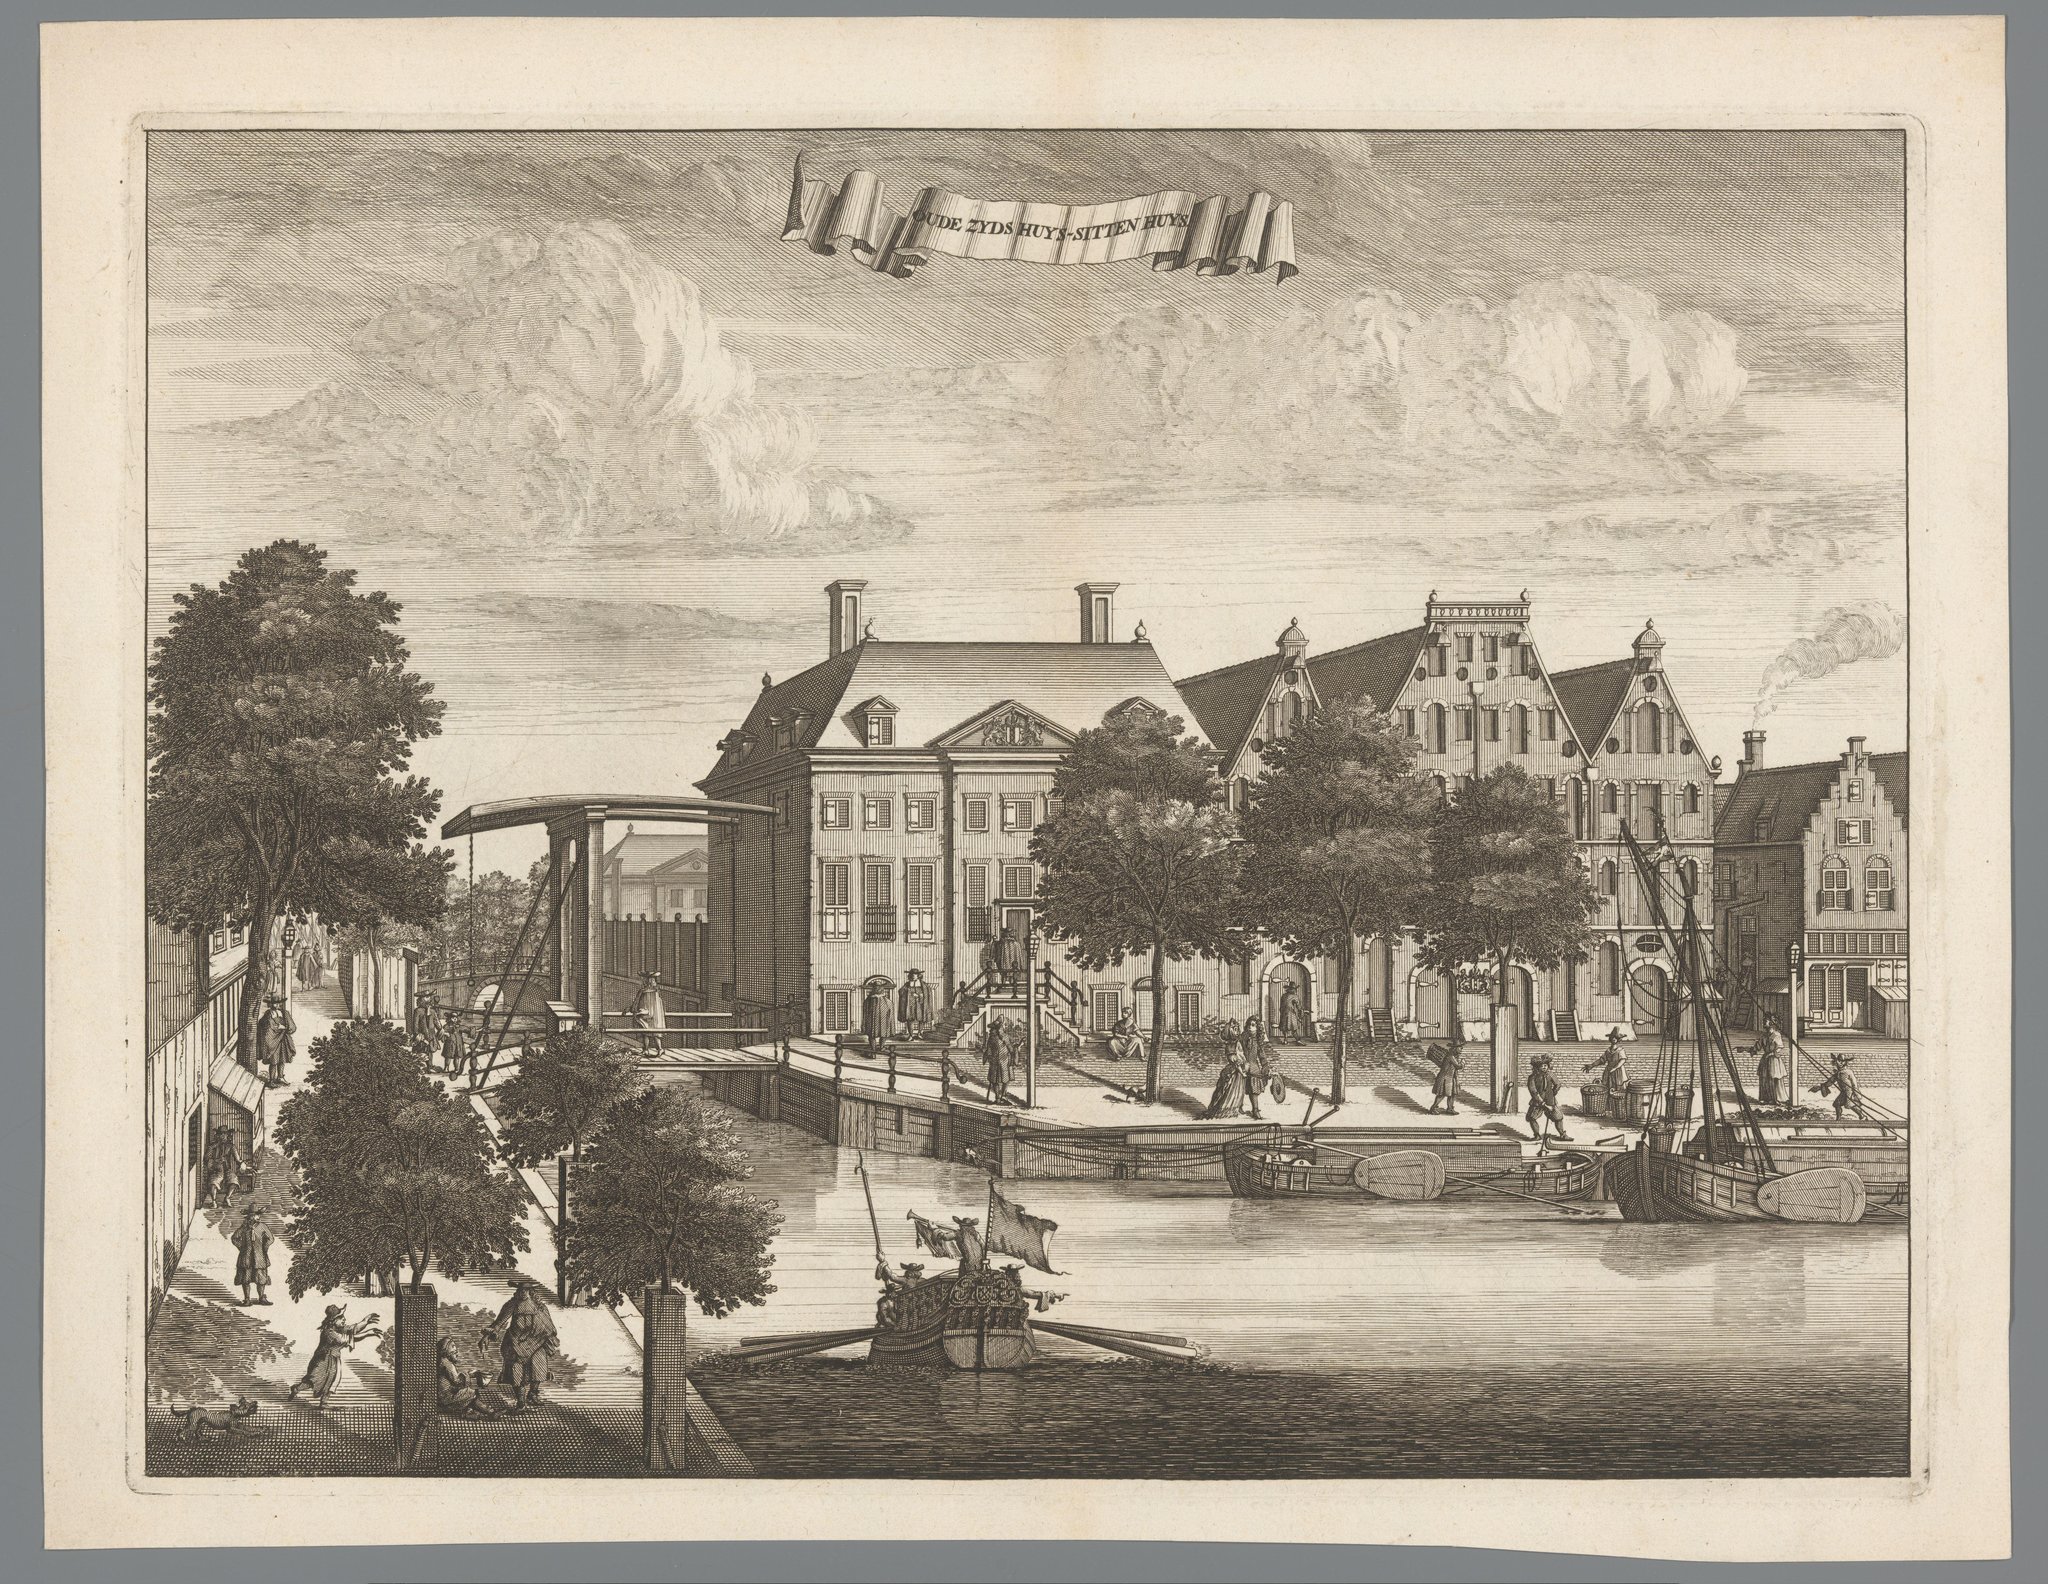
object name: book illustration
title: Gezicht op het Oudezijds Huiszittenhuis te Amsterdam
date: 1726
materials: paper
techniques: engraving, etching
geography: amsterdam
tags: public welfare, poorhouse, canals, waters (in city) (+ city(-scape) with figures, staffage), street (+ city(-scape) with figures, staffage)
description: Prent uit: Commelin, Caspar. Beschryvinge van Amsterdam, zynde een naukeruige verhandelinge van desselfs eerste oorspronk uyt den Huyse (…). Amsterdam: Andries van Damme et al., 1726, tussen p. 474 en 475.